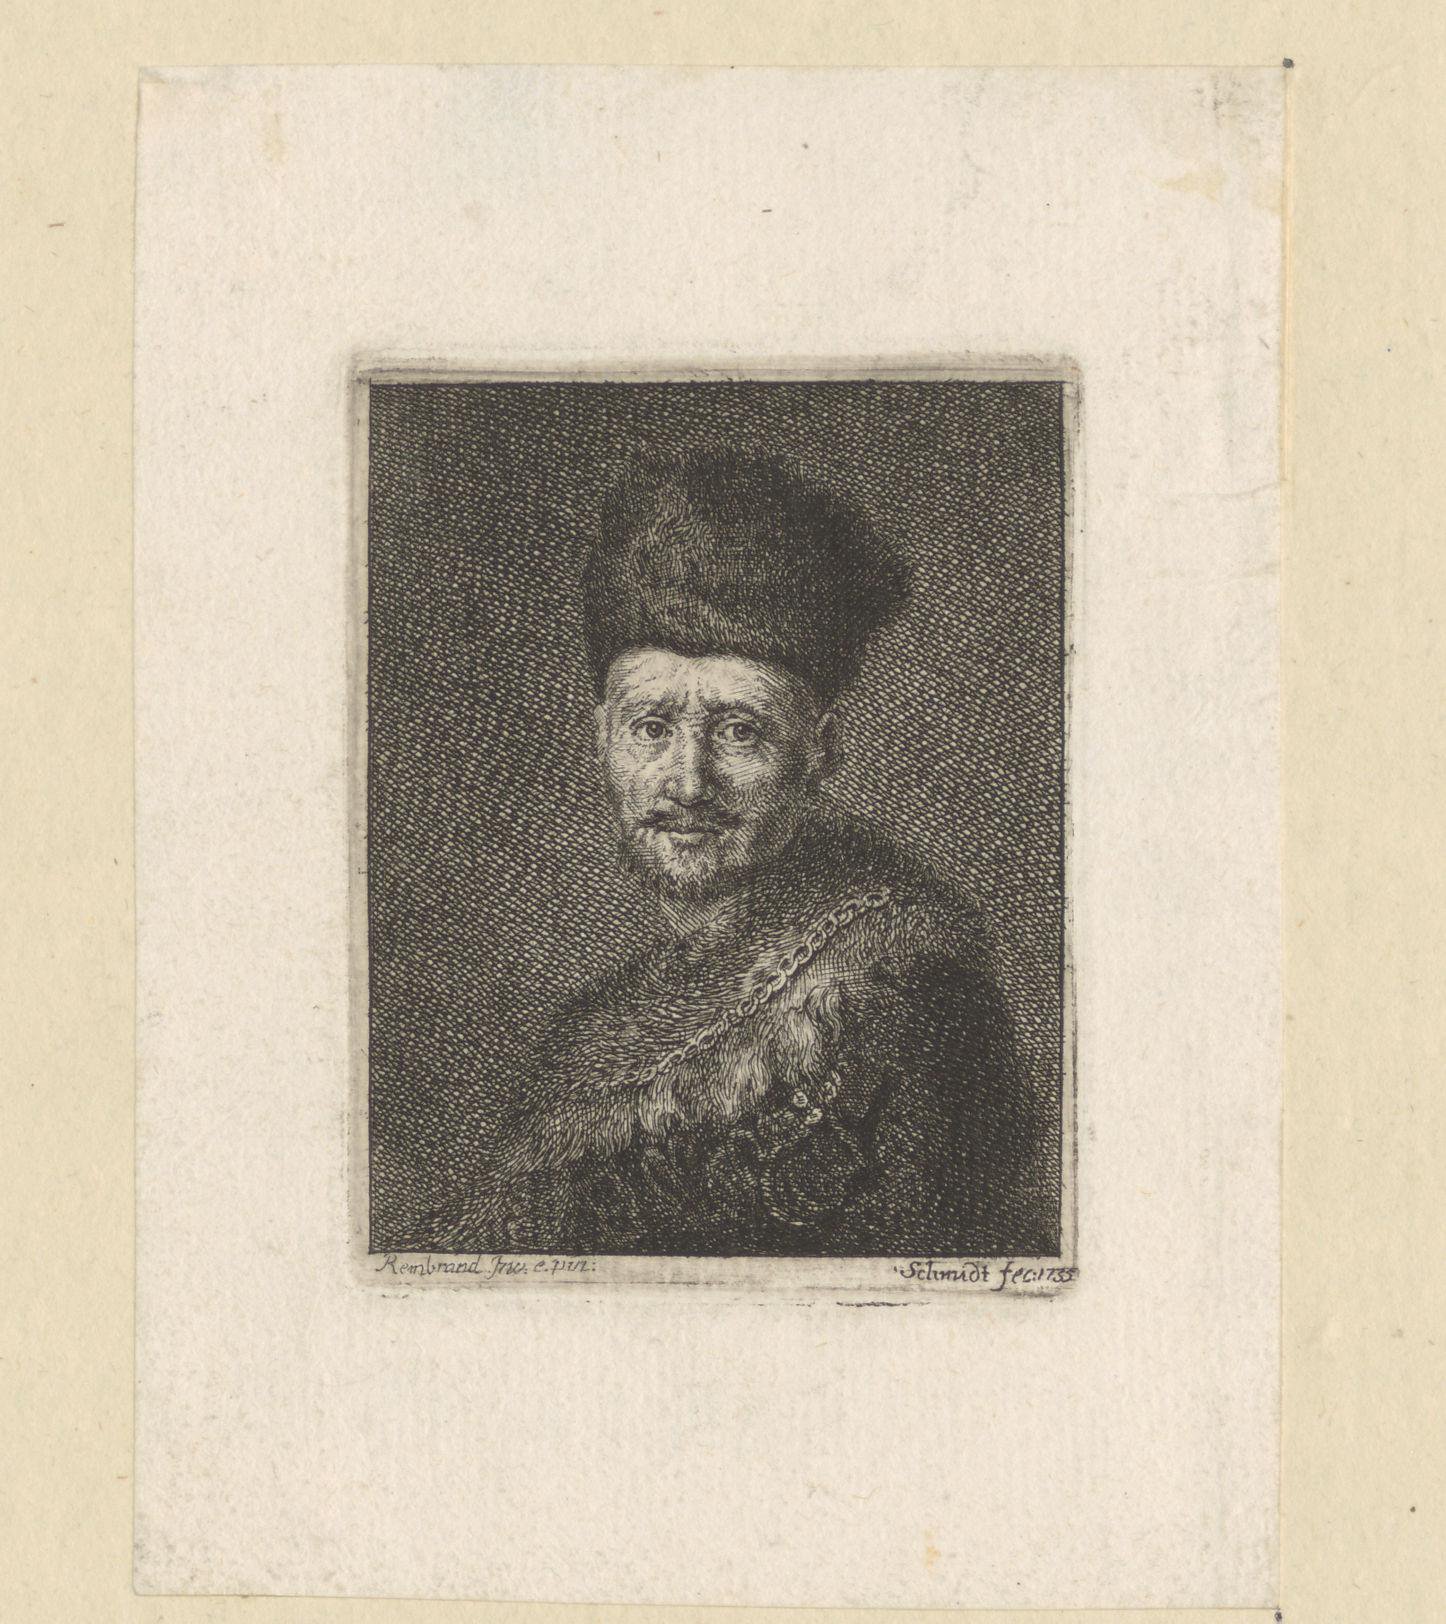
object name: print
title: Kop van een man met bontmuts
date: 1733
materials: paper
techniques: etching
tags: head-gear (with name), adult man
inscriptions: collector's mark: Lugt 2228, collector's mark: Lugt 240